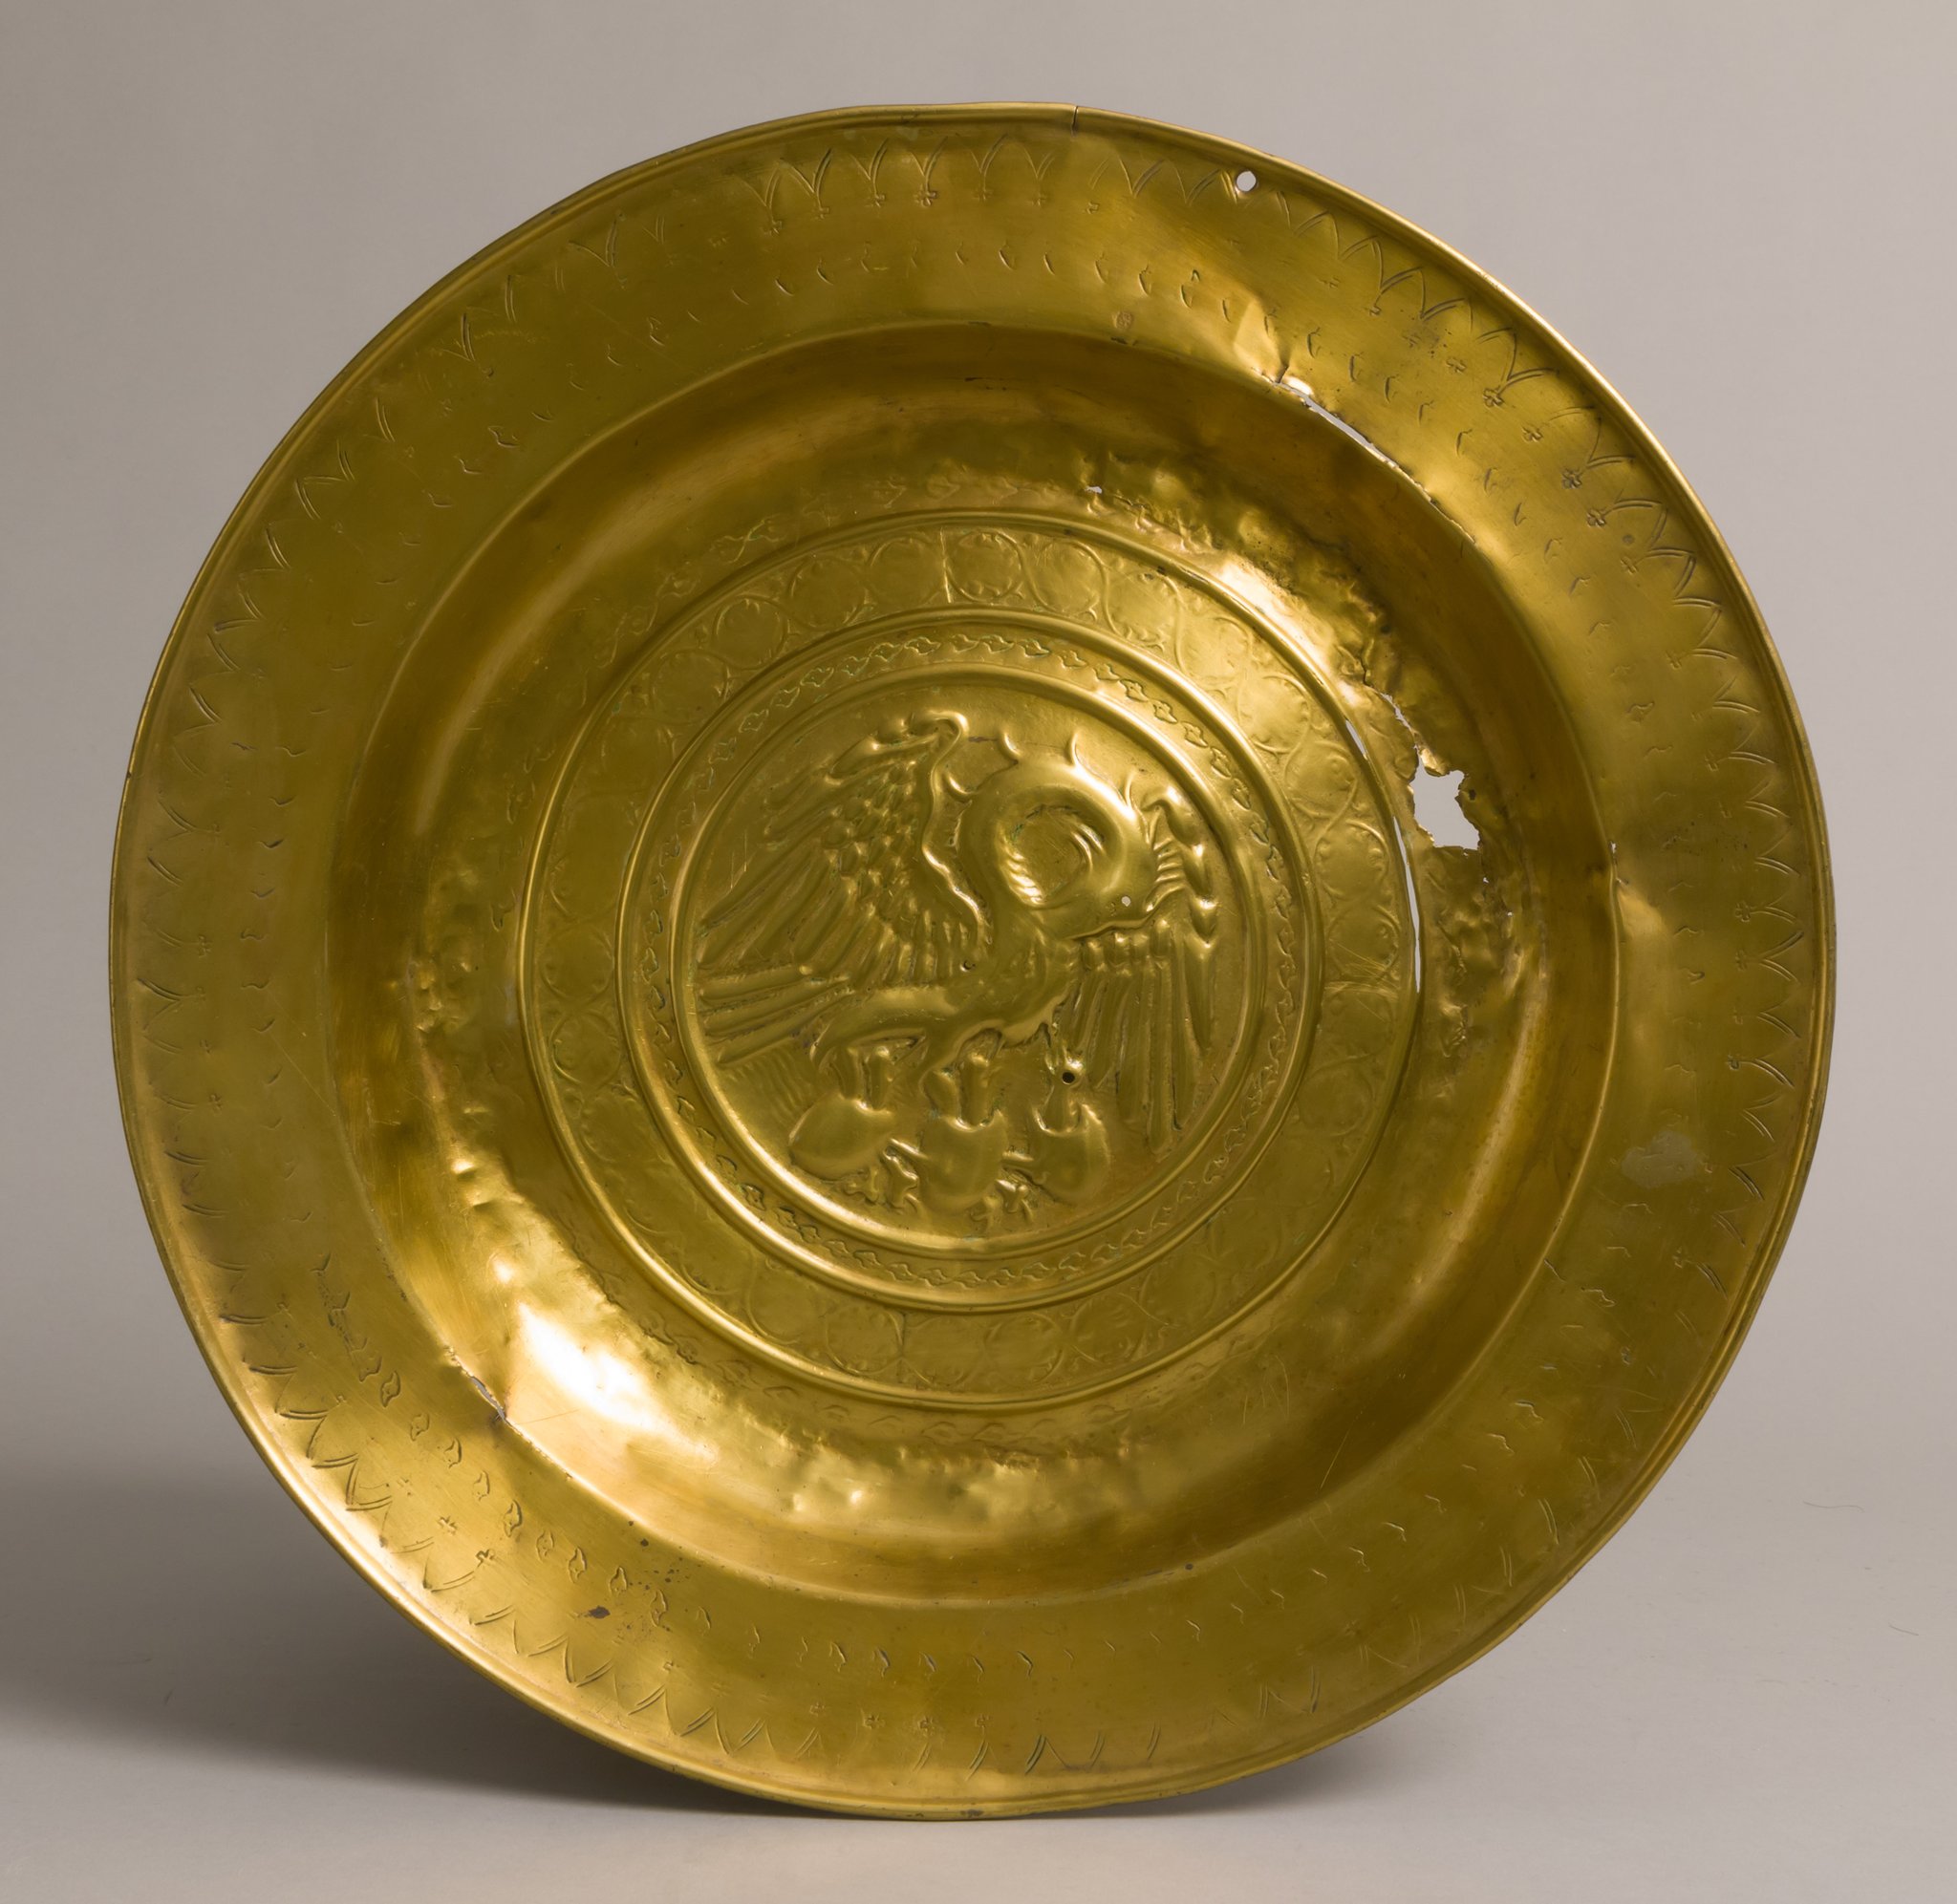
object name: dish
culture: german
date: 1501-1533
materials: brass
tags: birds